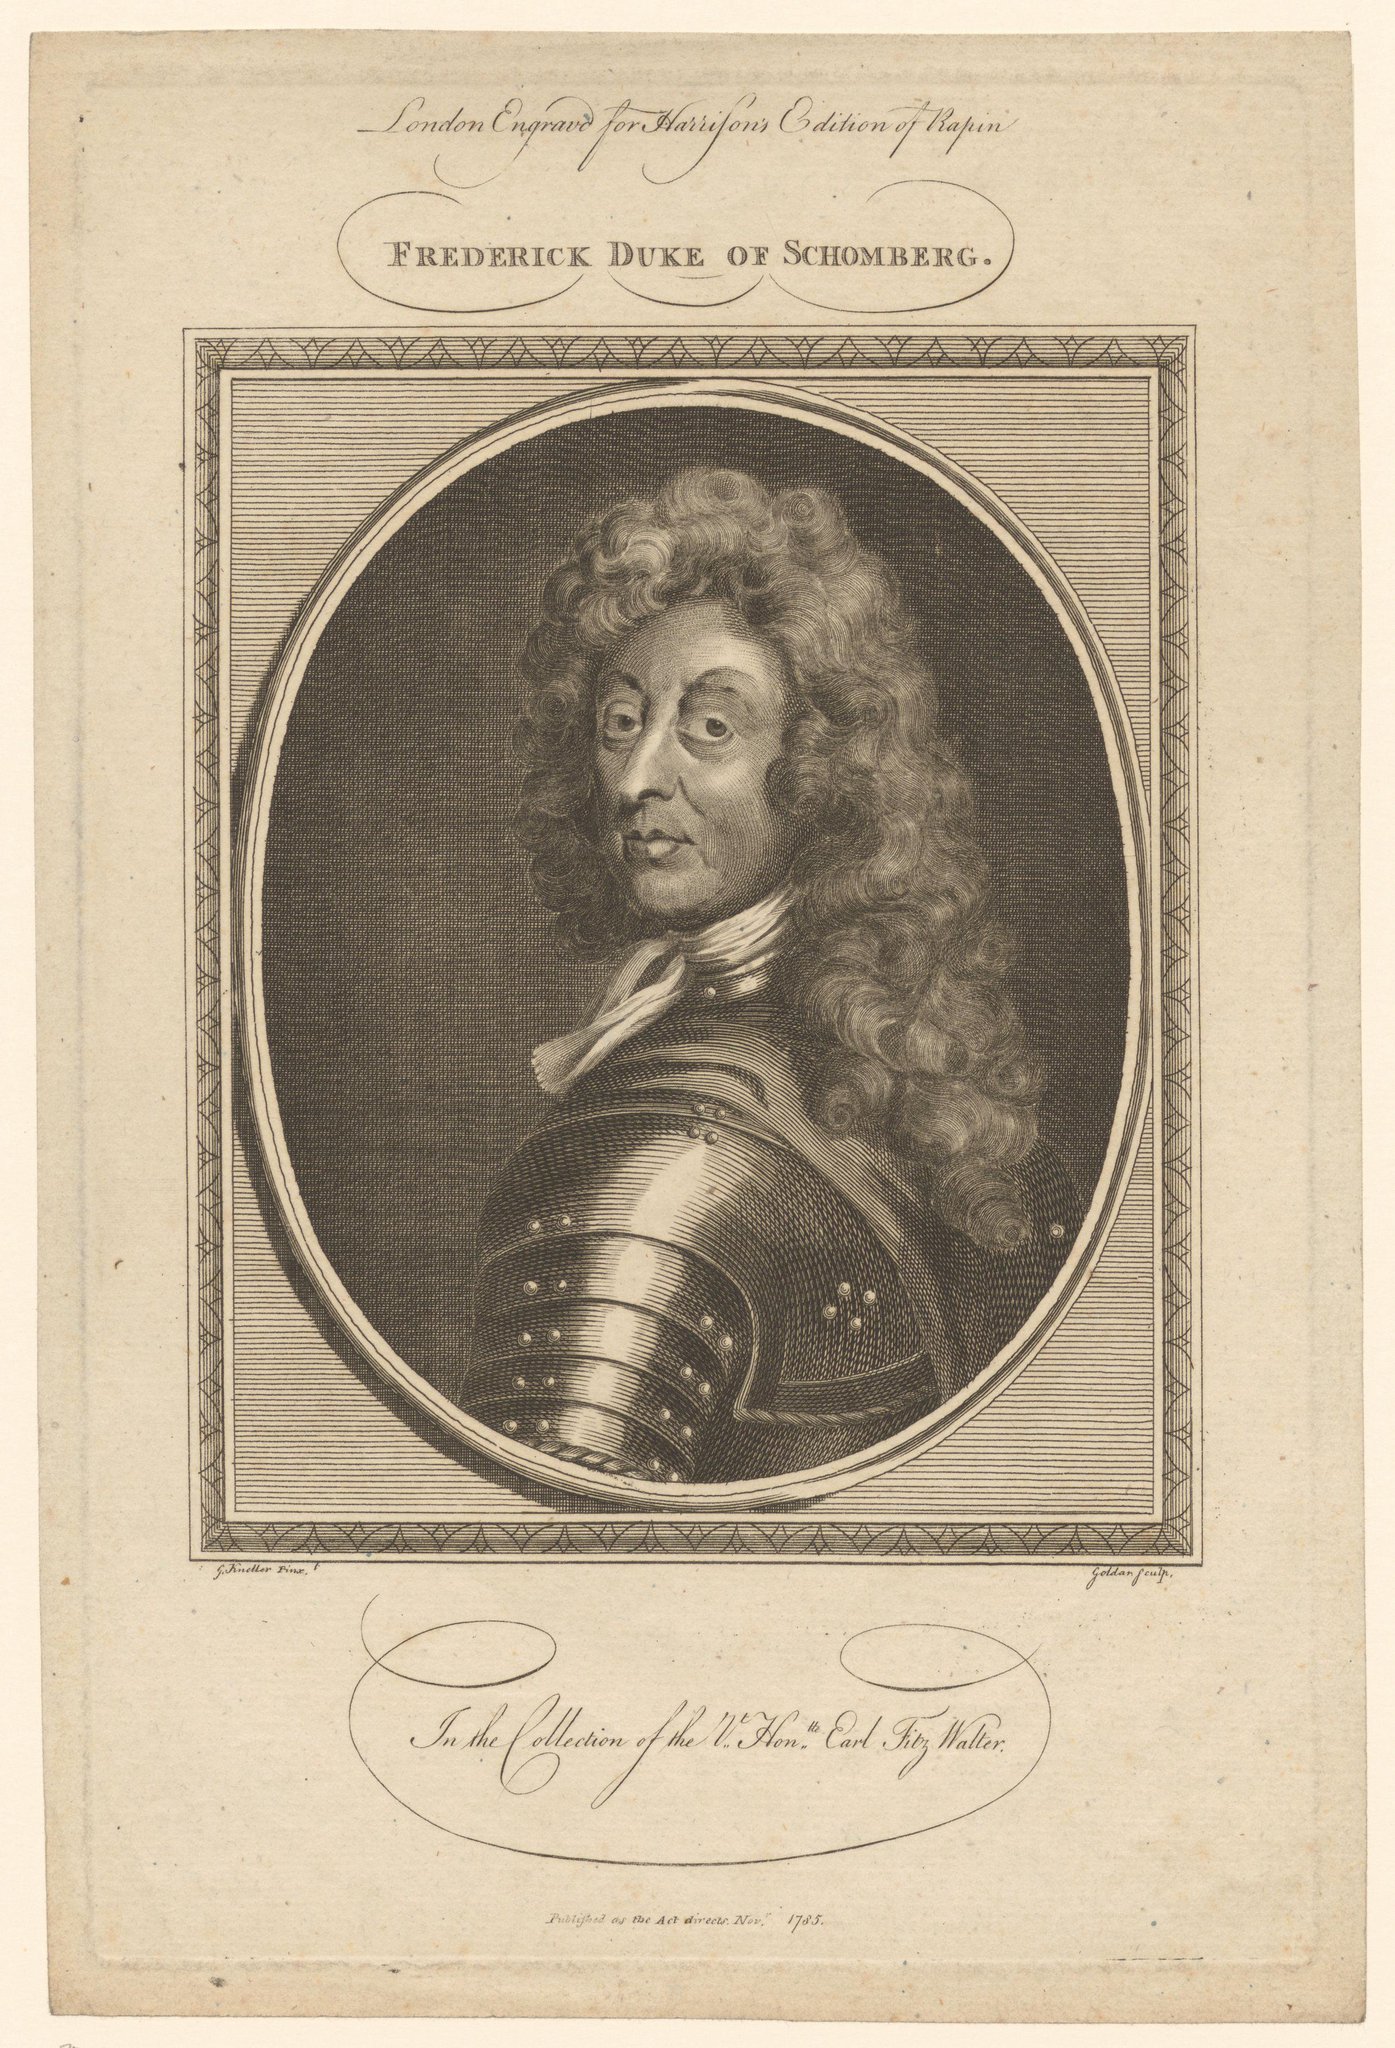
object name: print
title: Portret van Frederik van Schomberg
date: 1711-1785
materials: paper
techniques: engraving, etching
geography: england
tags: commander-in-chief, general, marshal, historical persons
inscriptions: collector's mark: Lugt 2228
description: Prent is gebruikt in: Rapin, Paul de. History of England. [Vertaald uit het Frans door] Nicolas Tindal. Londen: John Harrison, 1785.